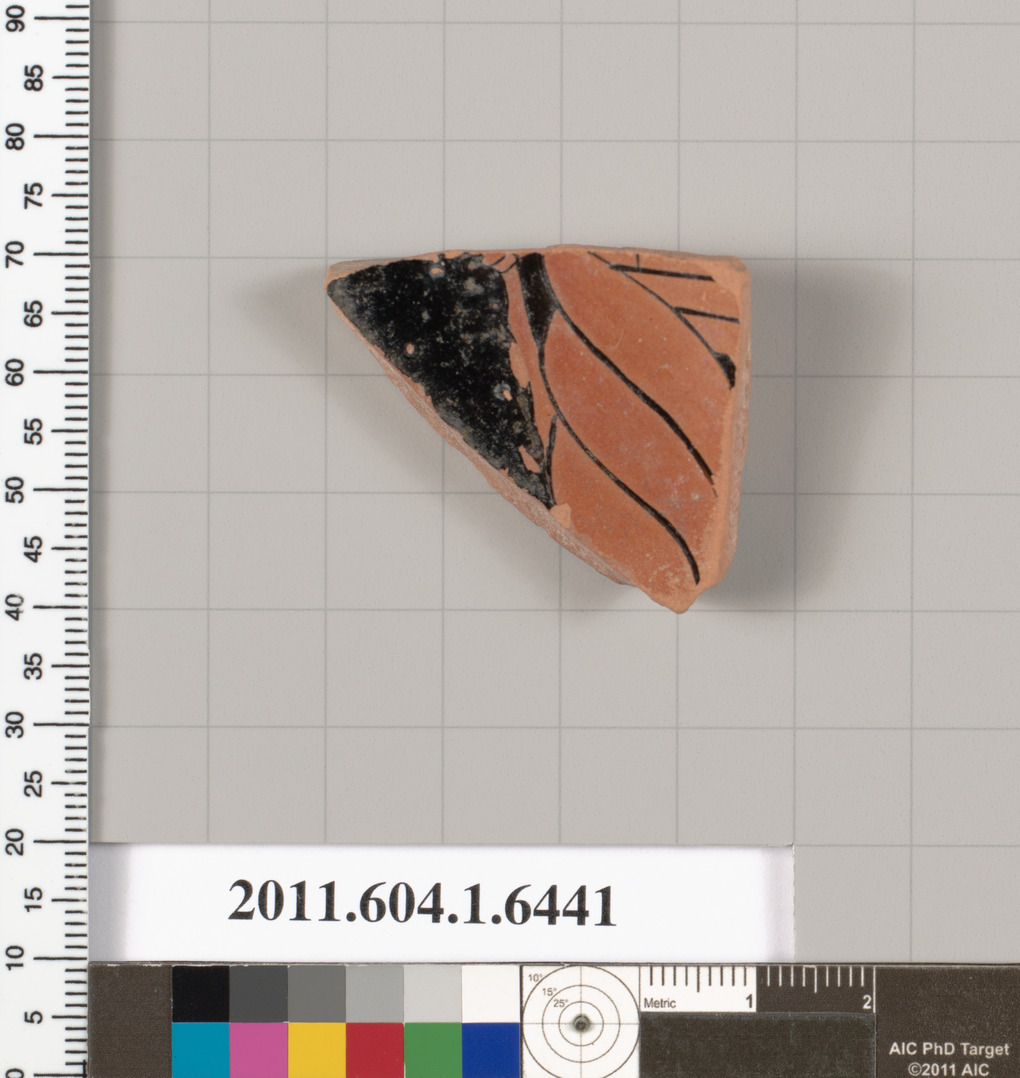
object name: kylix fragment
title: Terracotta fragment of a kylix (drinking cup)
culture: greek, attic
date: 490-480 BCE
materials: terracotta